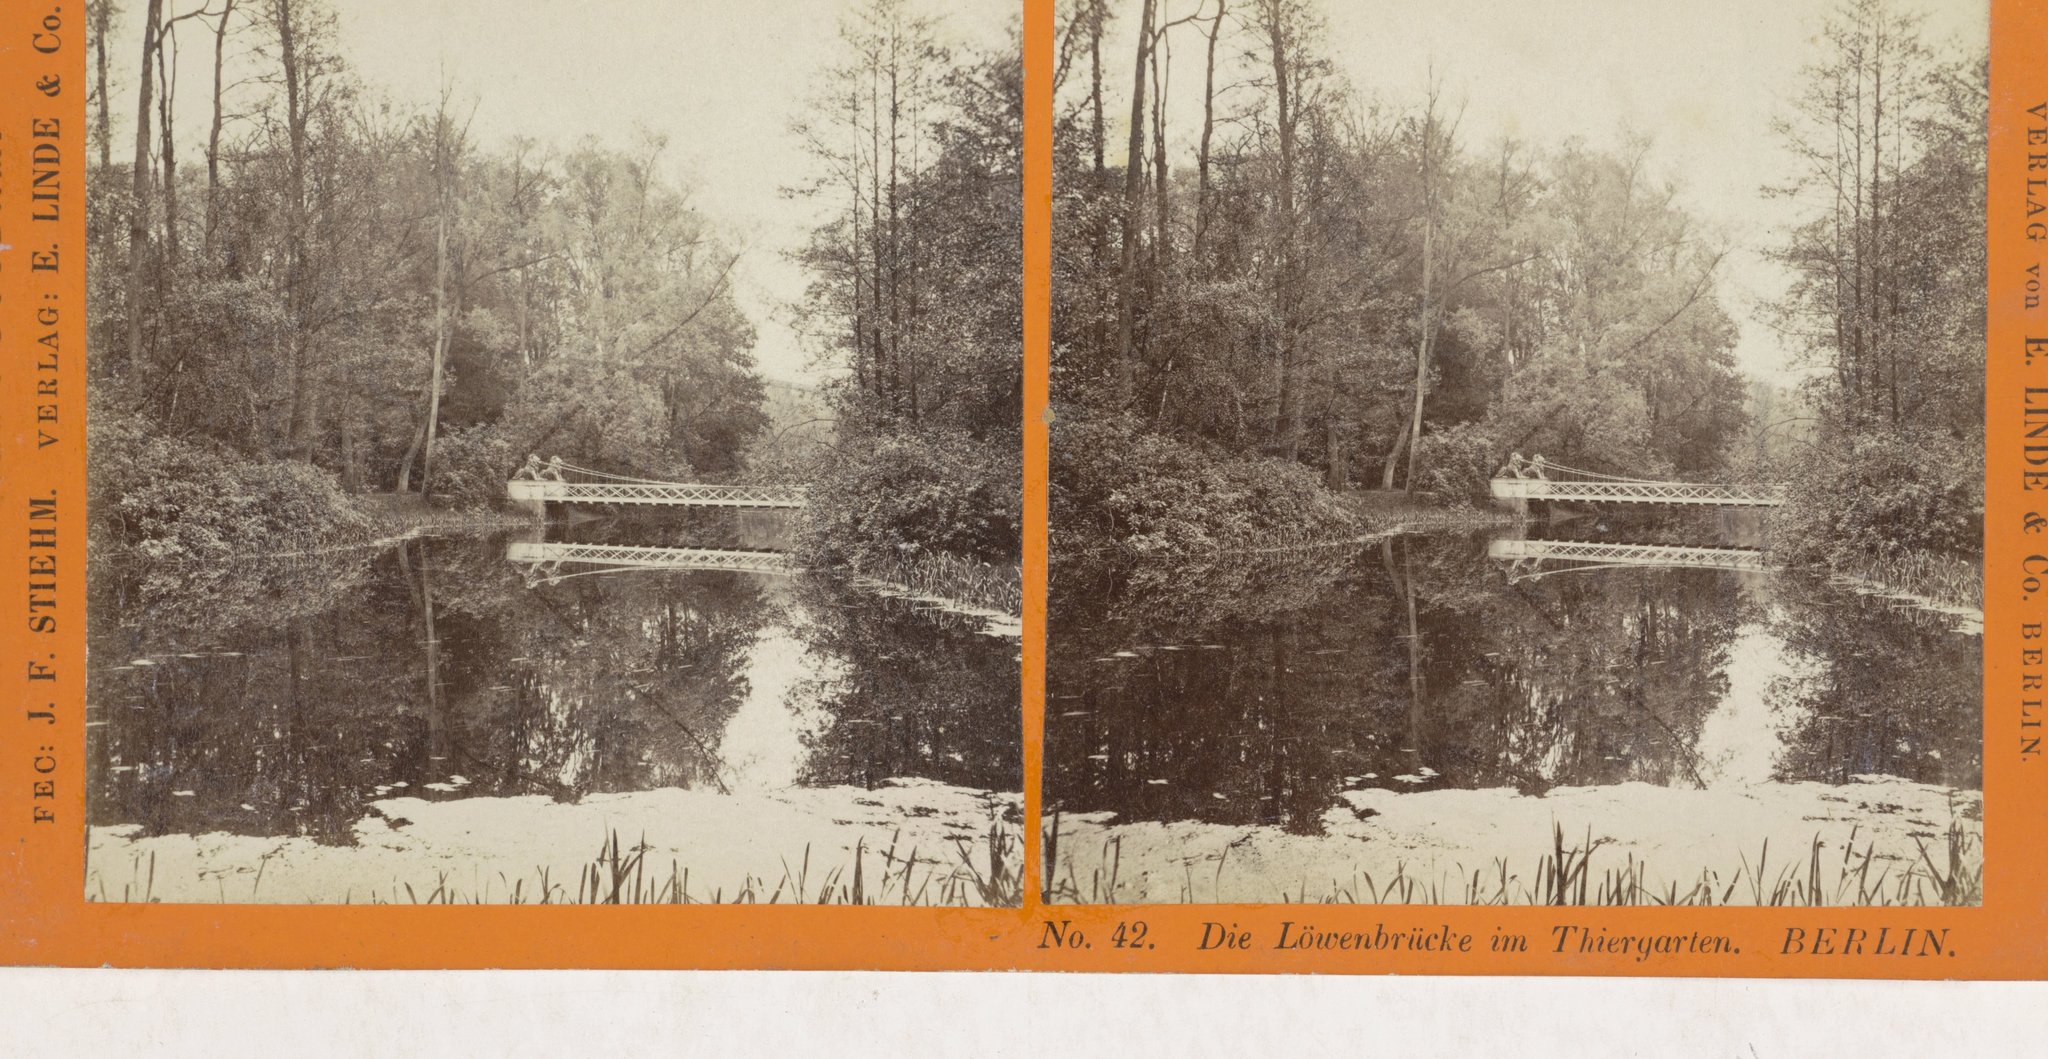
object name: stereograph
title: Ansichten von Deutschland / Berlin und Potsdam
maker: johann friedrich stiehm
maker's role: fotograaf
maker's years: 1826-1902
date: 1868-1870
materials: cardboard, paper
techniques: albumen print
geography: großer tiergarten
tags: suspension bridge, public gardens, park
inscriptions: number: ‘No. 42.’